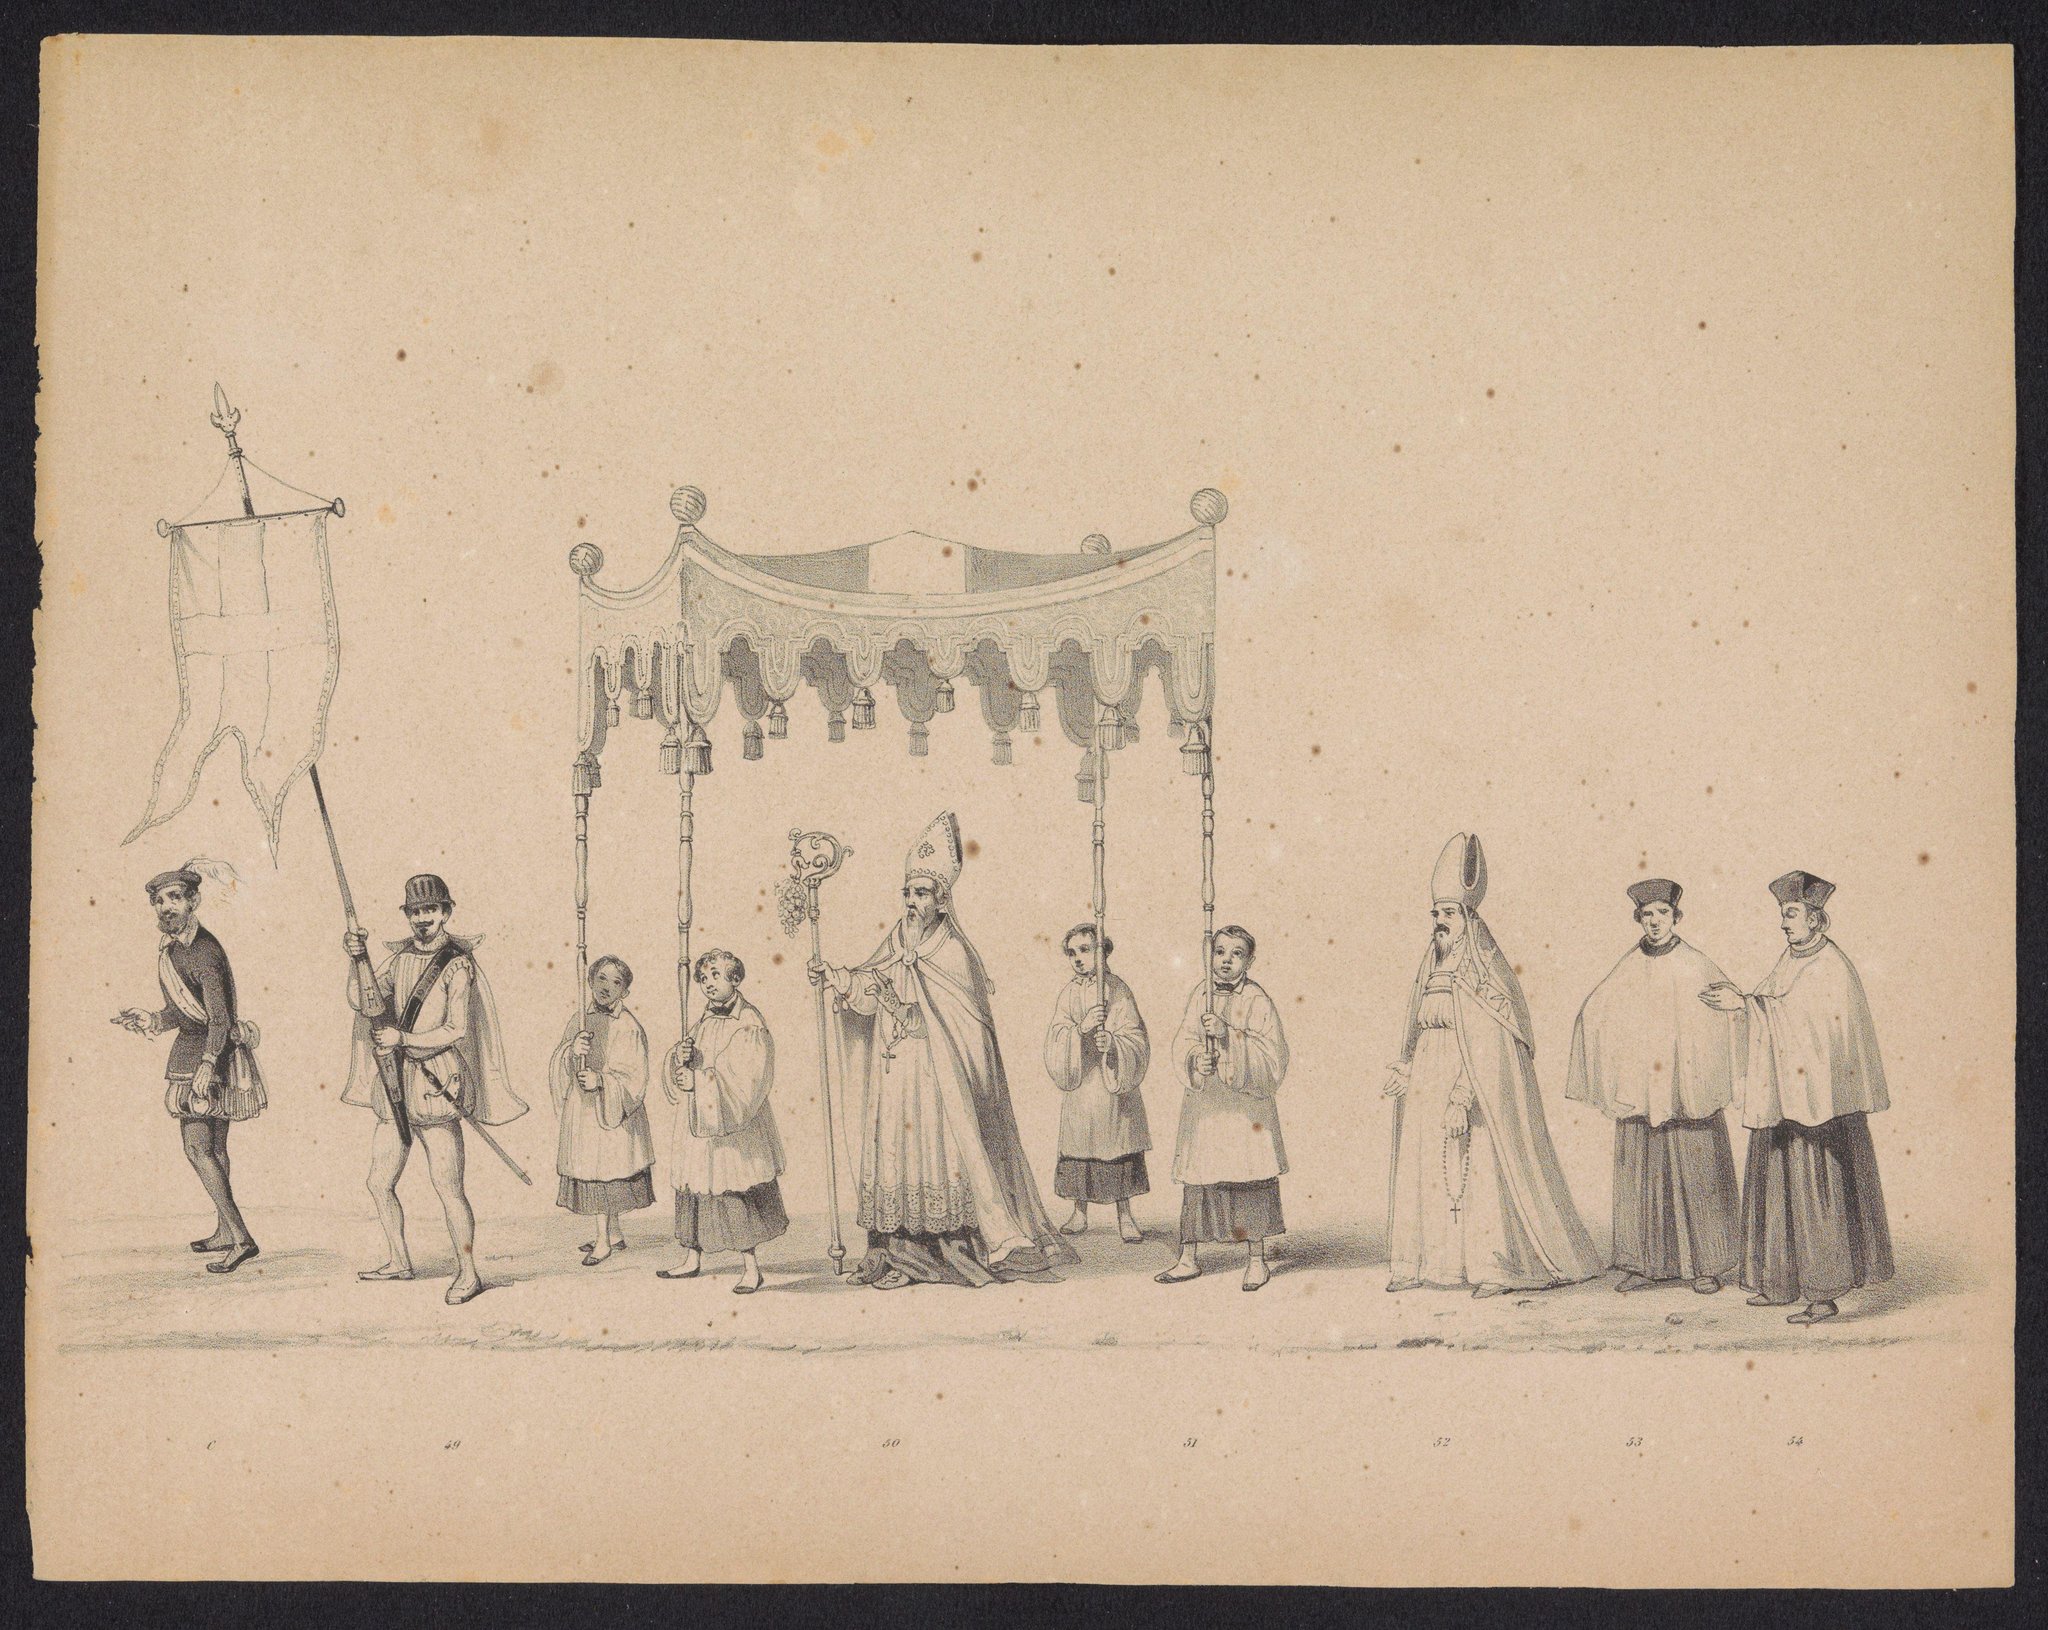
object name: print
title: Afbeelding van den gecostumeerden optogt, voorstellende den in togt van Philips II, Prins van Spanje, in Utrecht, den 3en October 1549, gehouden den 17en Junij 1846, door H.H. Studenten der Utrechtsche Hoogeschool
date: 1847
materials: paper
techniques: lithograph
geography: netherlands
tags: philip ii of spain, students' pageant, costumes used in pageants, utrecht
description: Historische gekostumeerde optocht van de studenten van de Utrechtse Hogeschool gehouden op 17 juni 1846 ter gelegenheid van het 210-jarig bestaan van de Hogeschool. De optocht verbeeldt de intocht van Filips II in Utrecht op 3 oktober 1549. Plaat met de groepen genummerd 49-54. Onderdeel van de serie van 22 aanelkaar te plakken losse bladen.